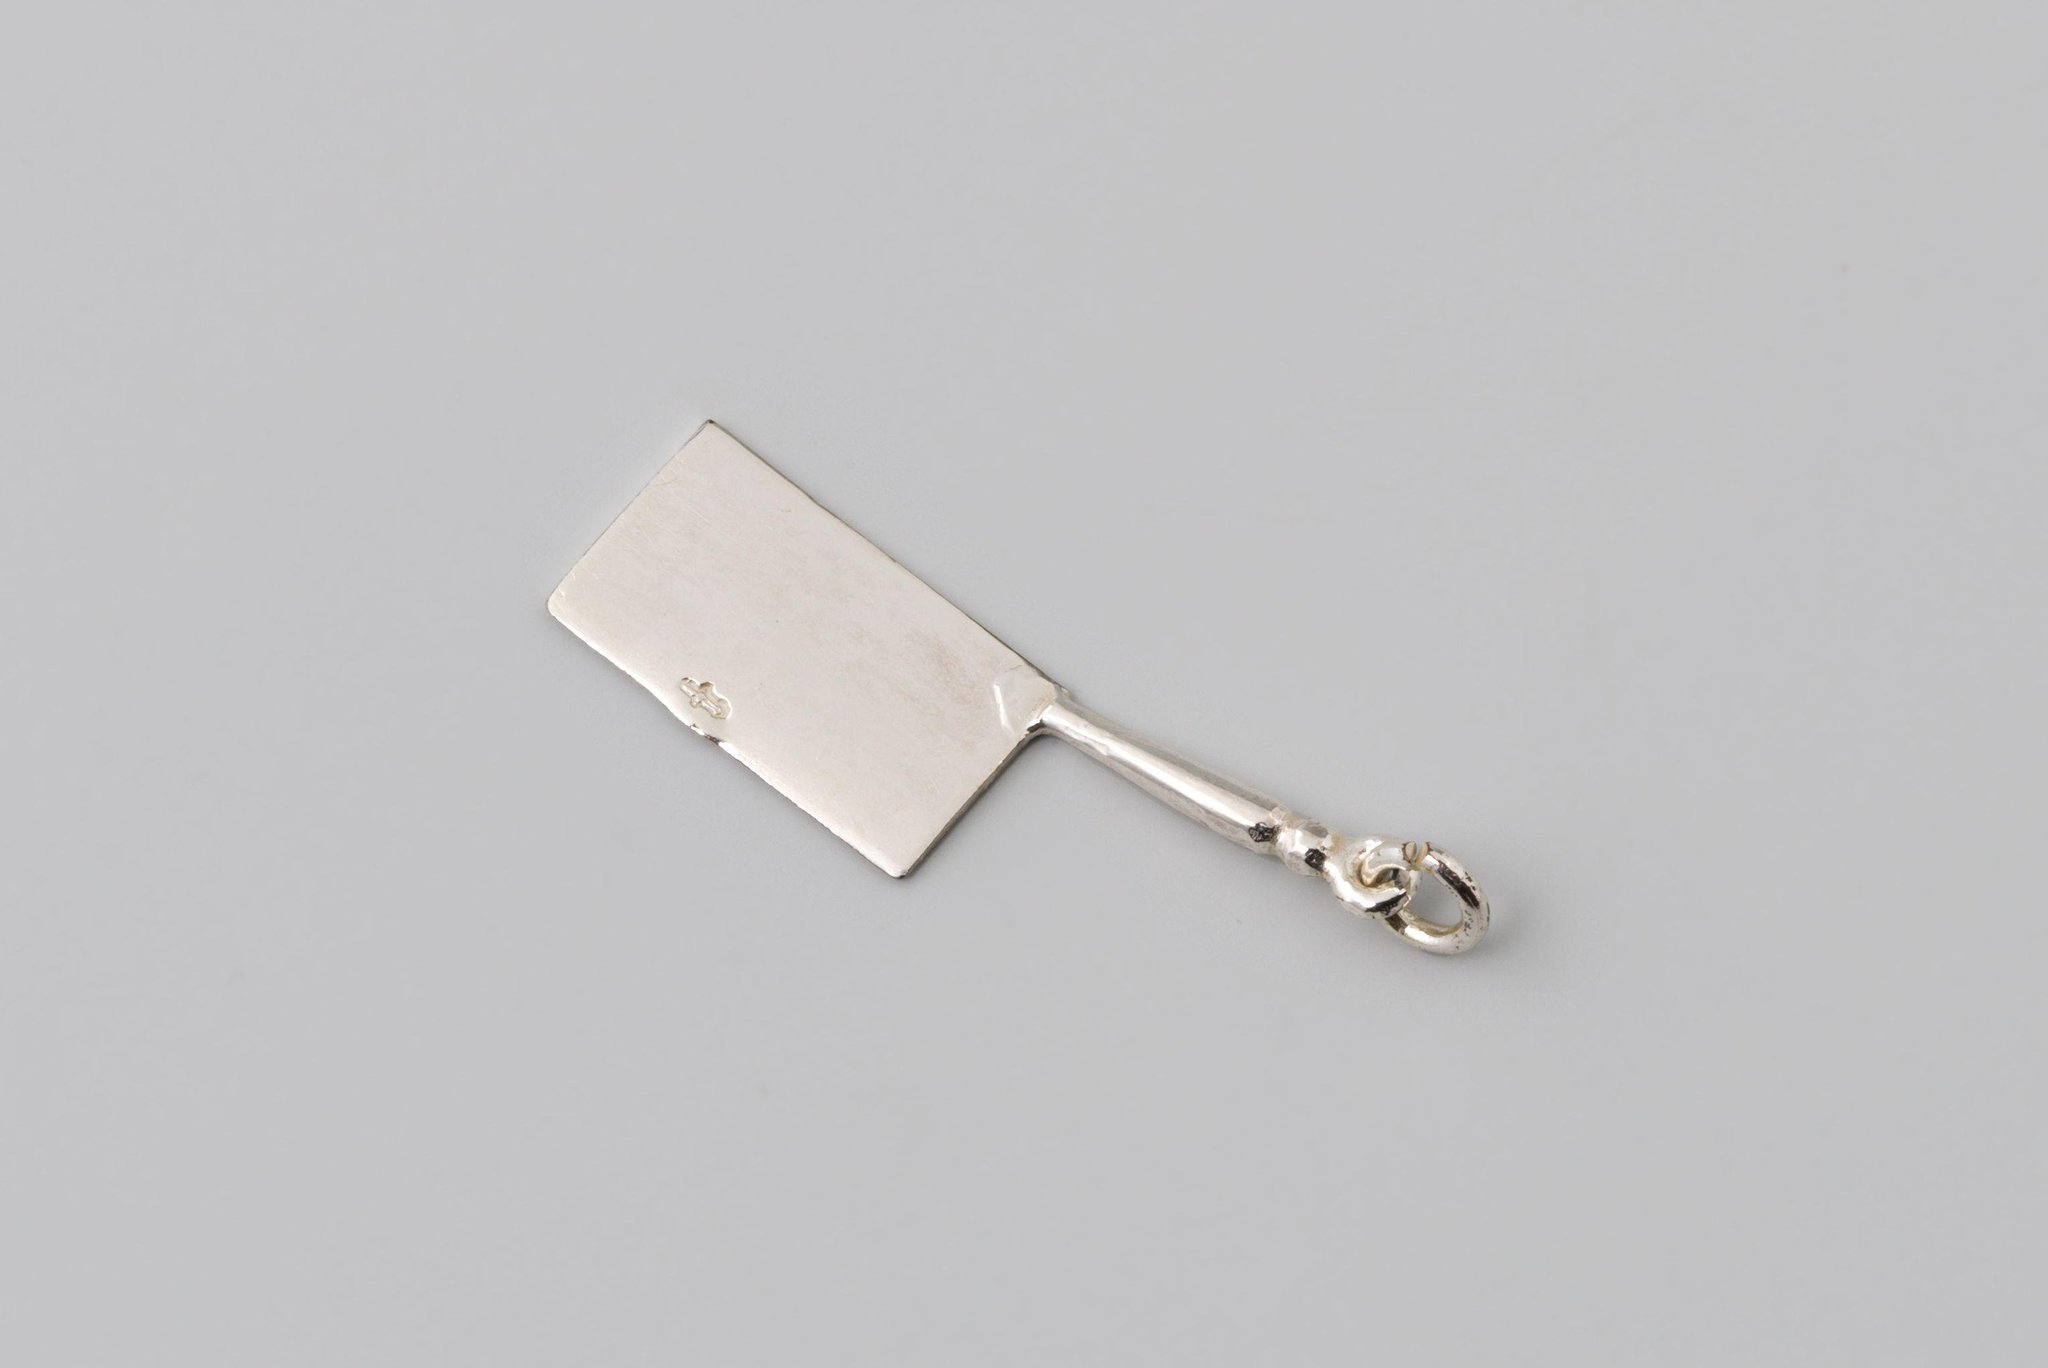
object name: food chopper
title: Hakmes van zilver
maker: Anonymous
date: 1814-1906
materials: silver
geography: netherlands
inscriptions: hallmark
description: Hakmes van zilver met ronde steel waaraan ring en met rechthoekig blad.